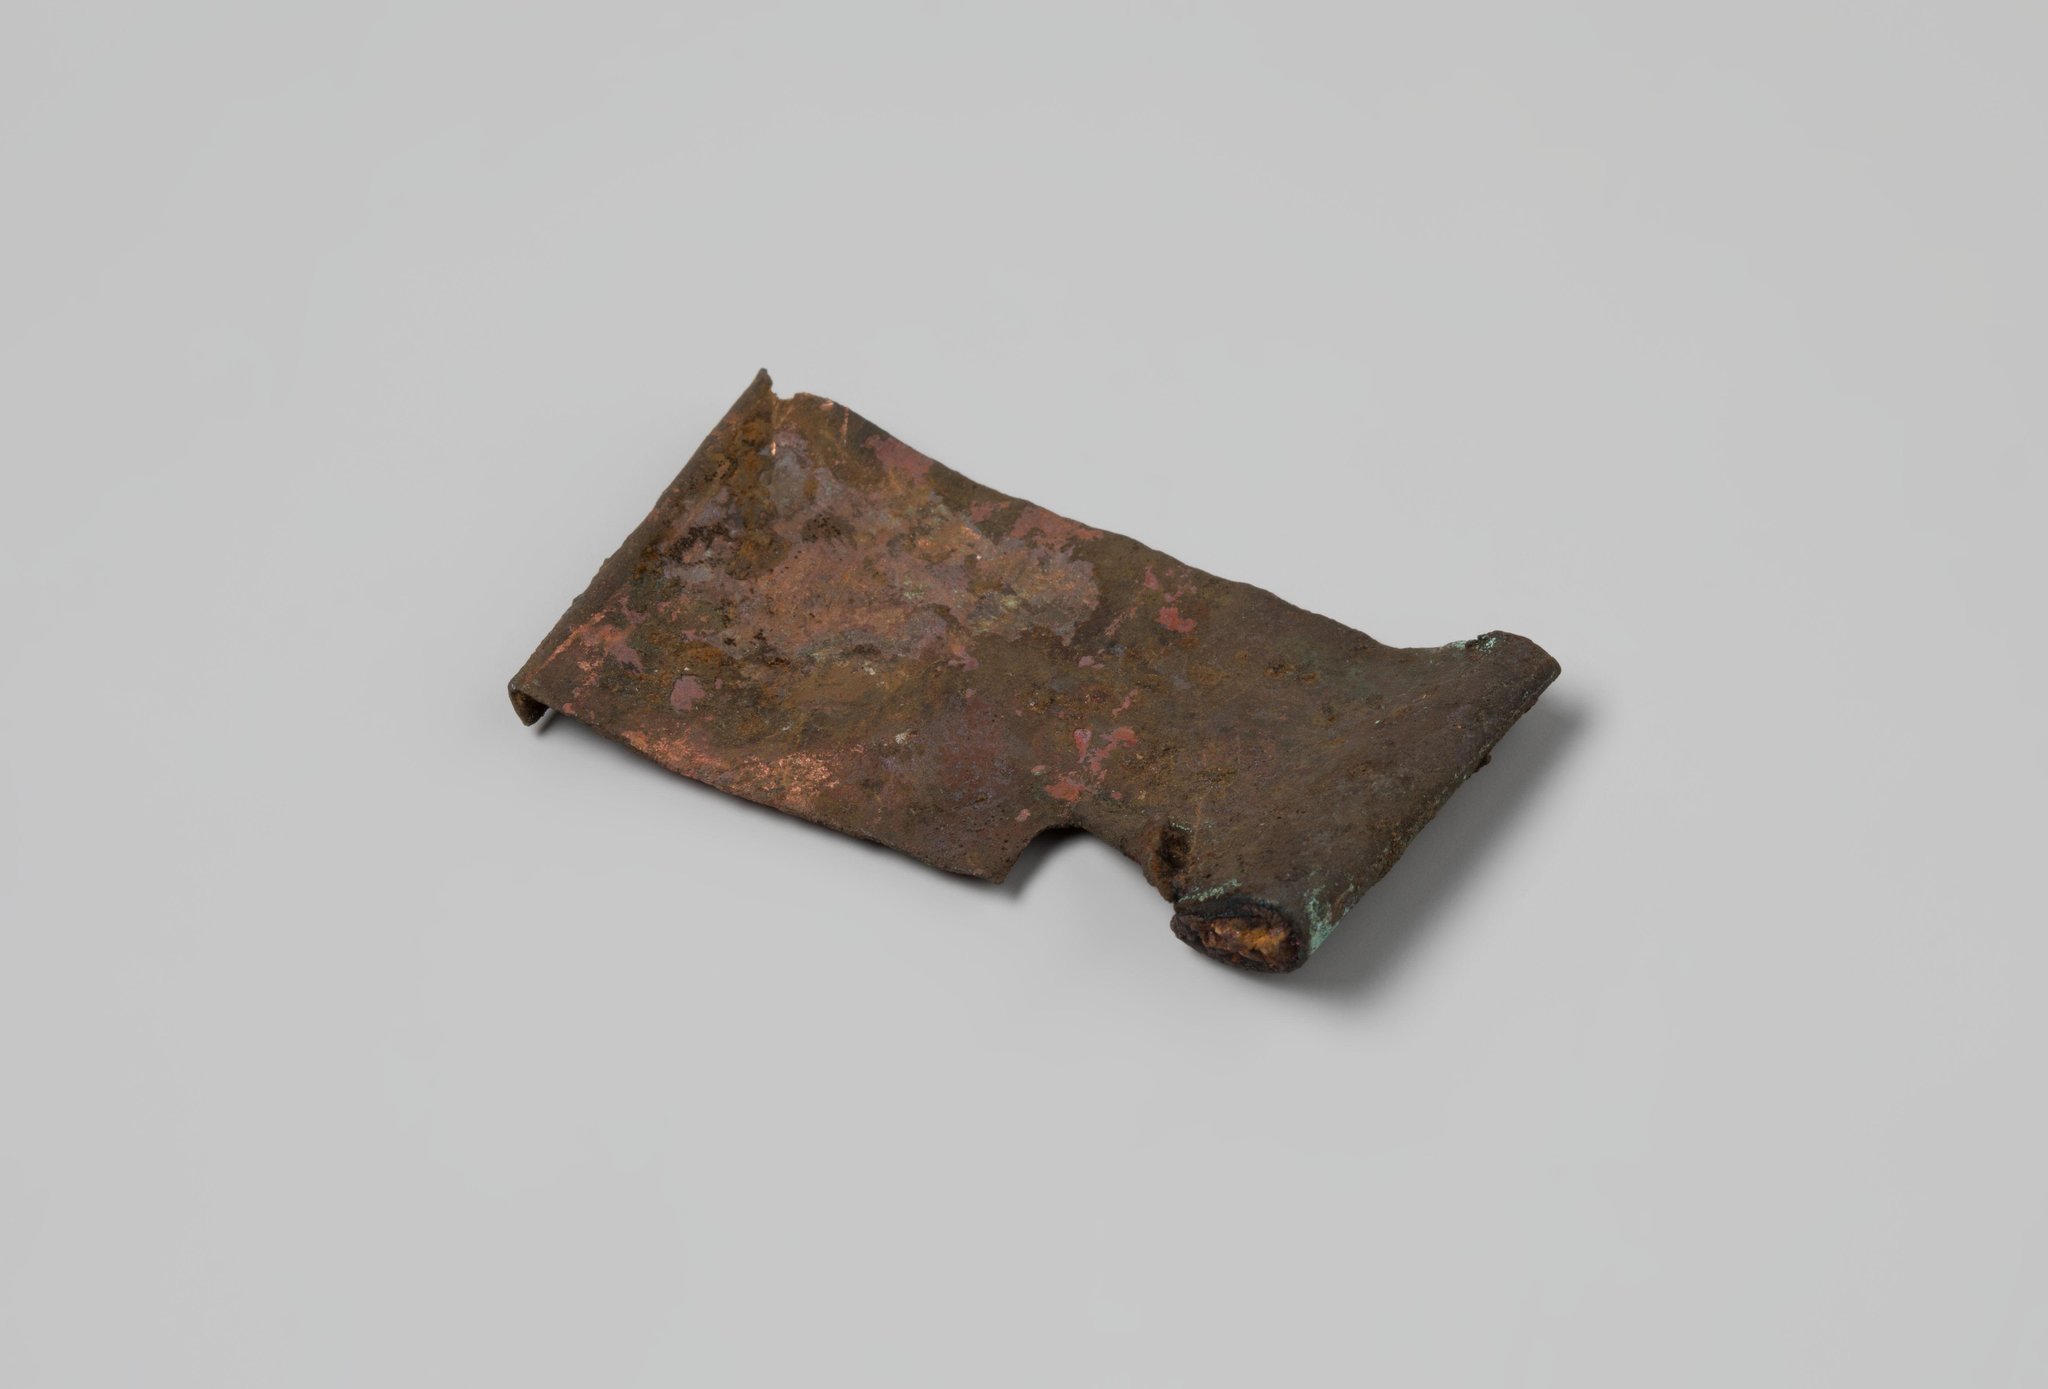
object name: beslag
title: Beslag uit het wrak van de Oost-Indiëvaarder Hollandia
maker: Anonymous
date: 1700-1743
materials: copper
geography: netherlands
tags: verenigde oostindische compagnie, hollandia (schip), annet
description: Fittings, bands and bracing, flat; id. NG 1980-27H3053.